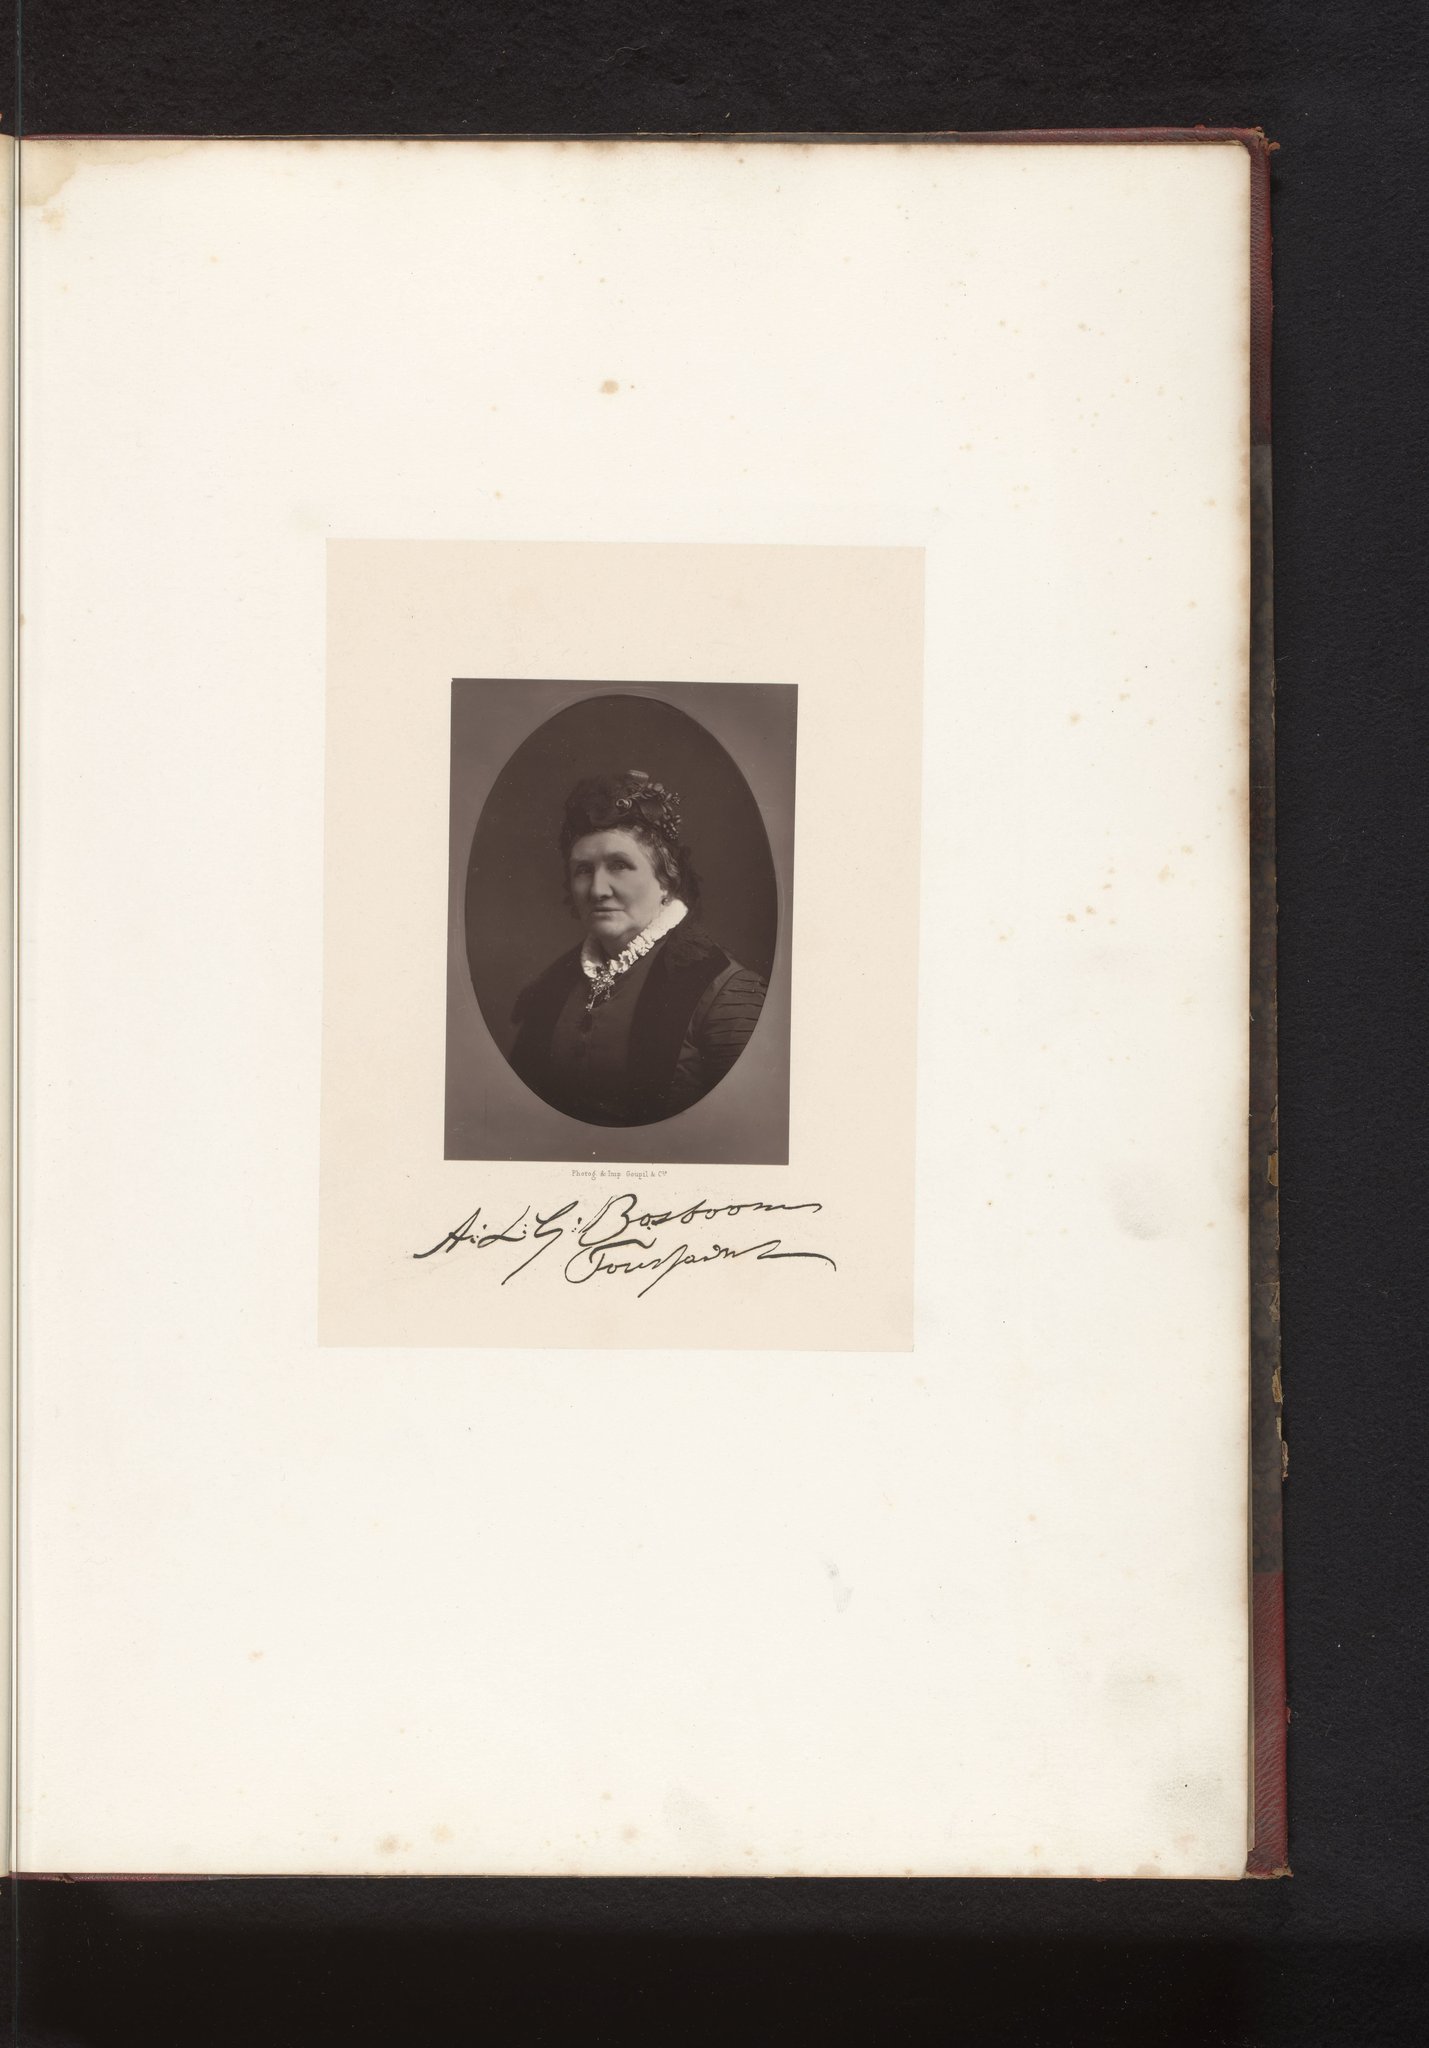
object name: page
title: Portret van Anna Louisa Geertruyda Bosboom-Toussaint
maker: Anonymous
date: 1878-1887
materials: paper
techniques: woodburytype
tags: the hague, anna louisa geertruyda bosboom-toussaint, historical persons - bb - woman, writer, poet, author